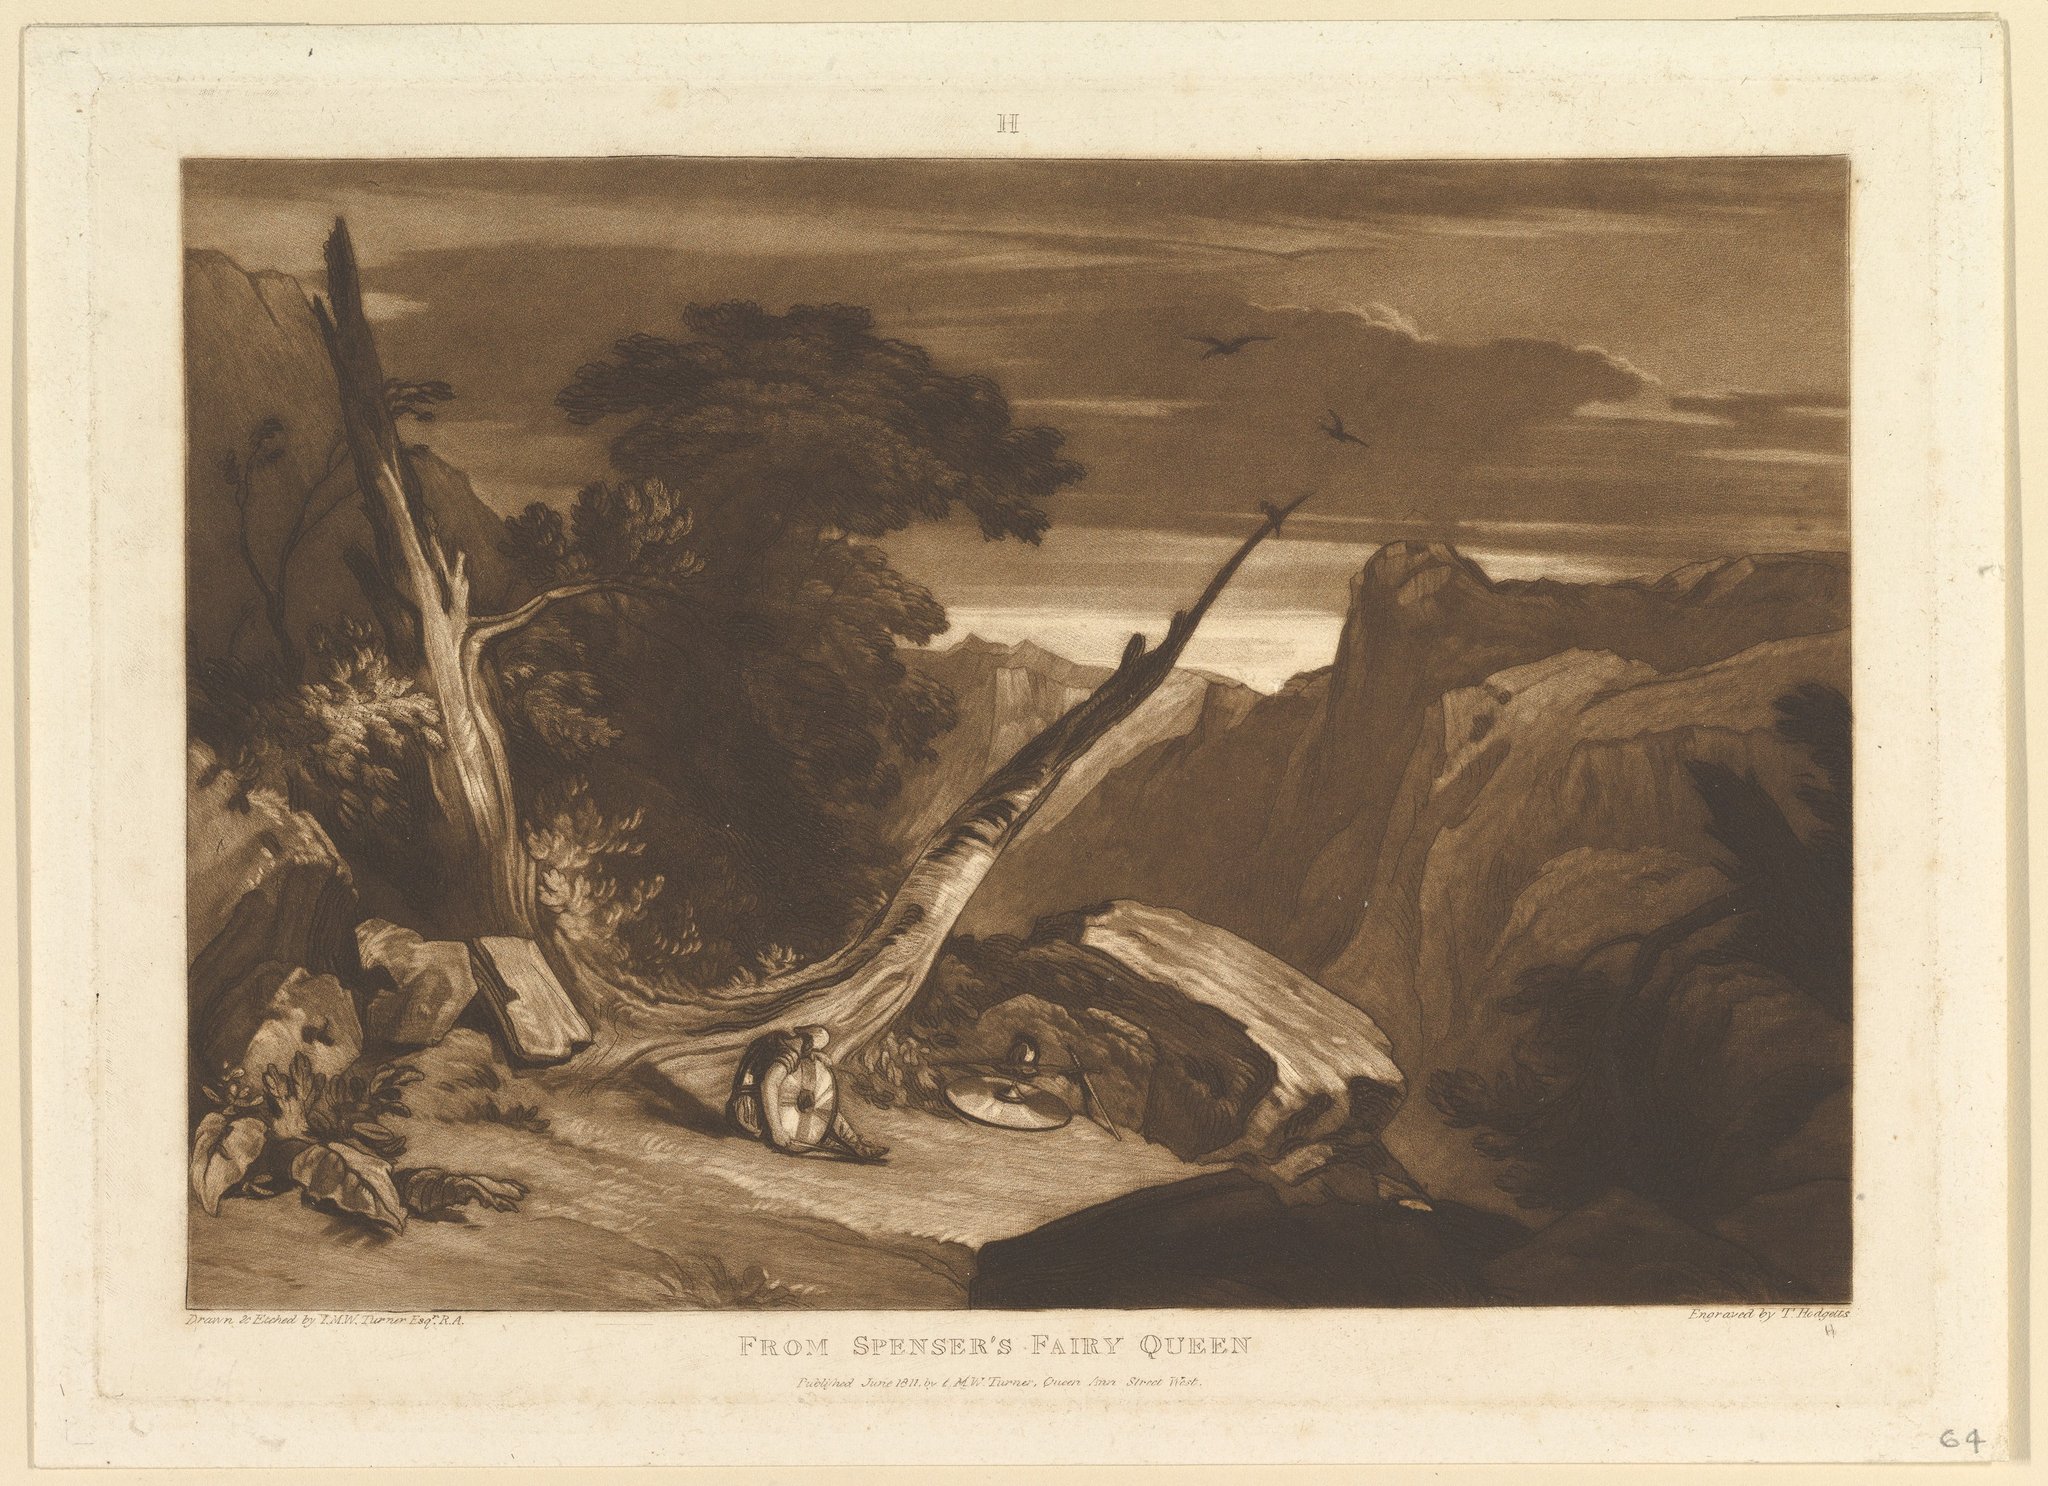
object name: print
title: From Spenser's Fairy Queen (Liber Studiorum, part VII, plate 36)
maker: joseph mallord william turner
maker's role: artist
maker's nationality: british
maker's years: 1775-1851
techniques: etching, mezzotint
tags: shields,men,landscapes,trees